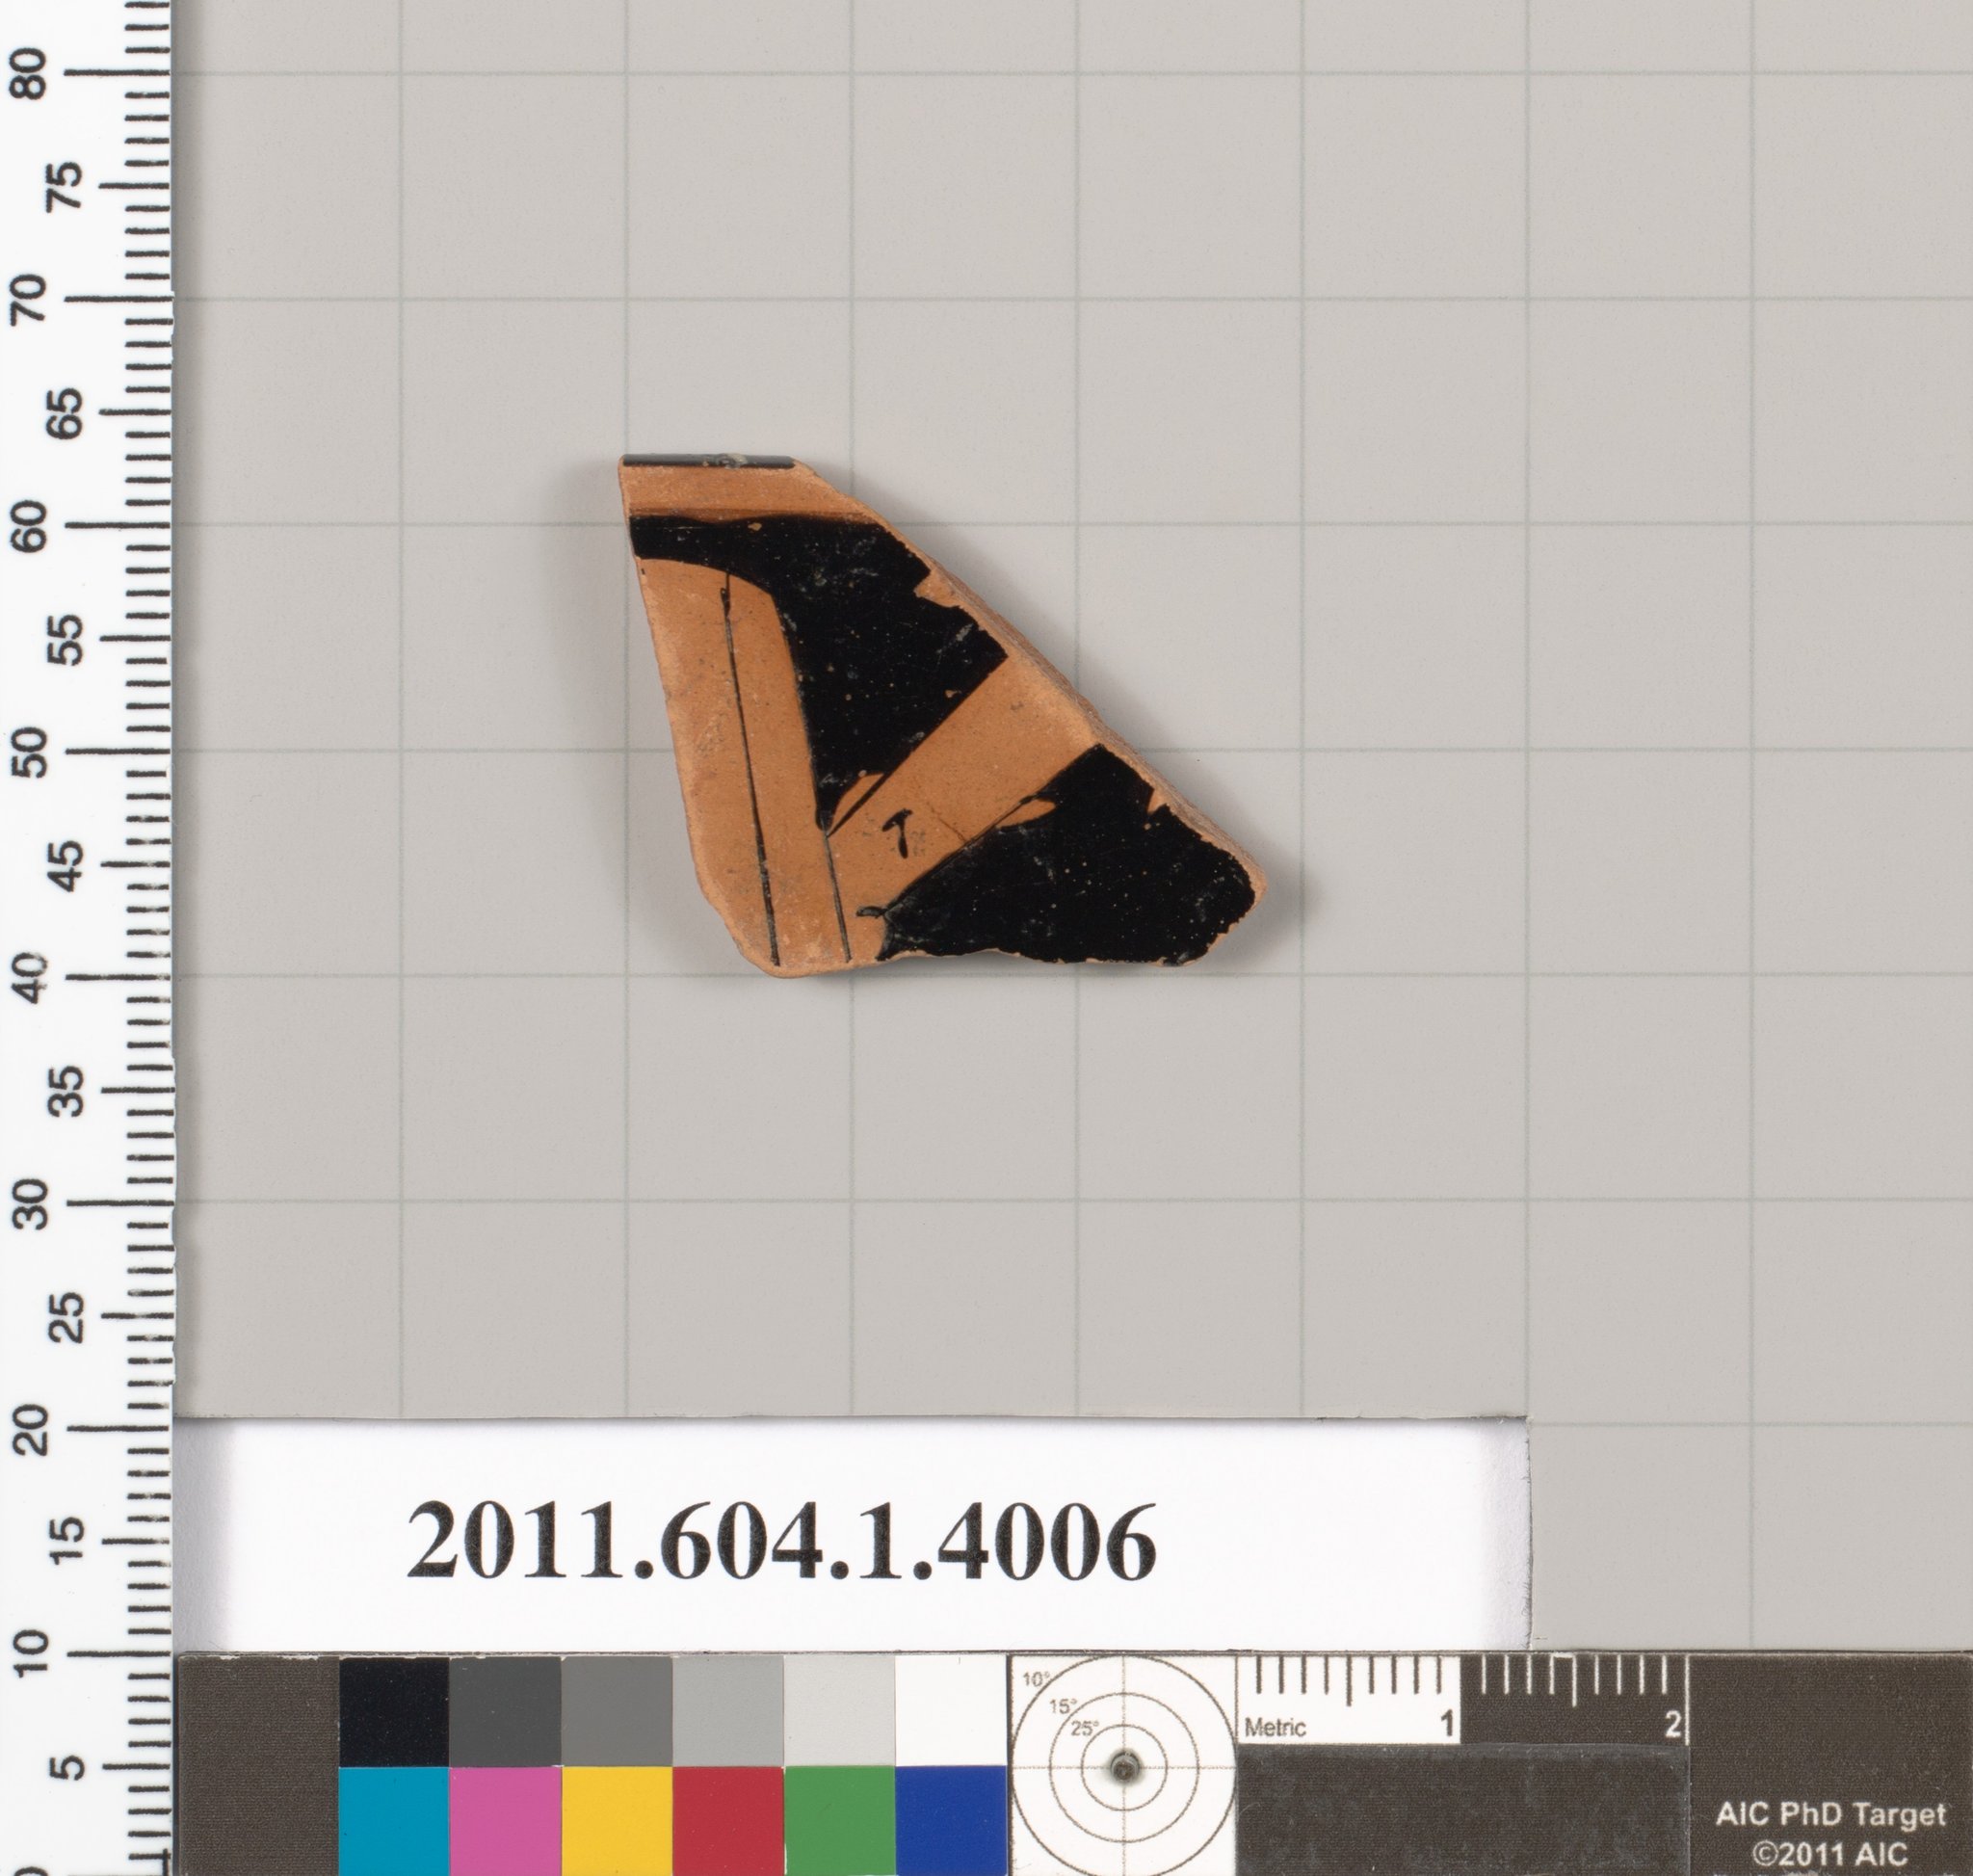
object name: kylix fragment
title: Terracotta rim fragment of a kylix (drinking cup)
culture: greek, attic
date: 475-451 BCE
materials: terracotta